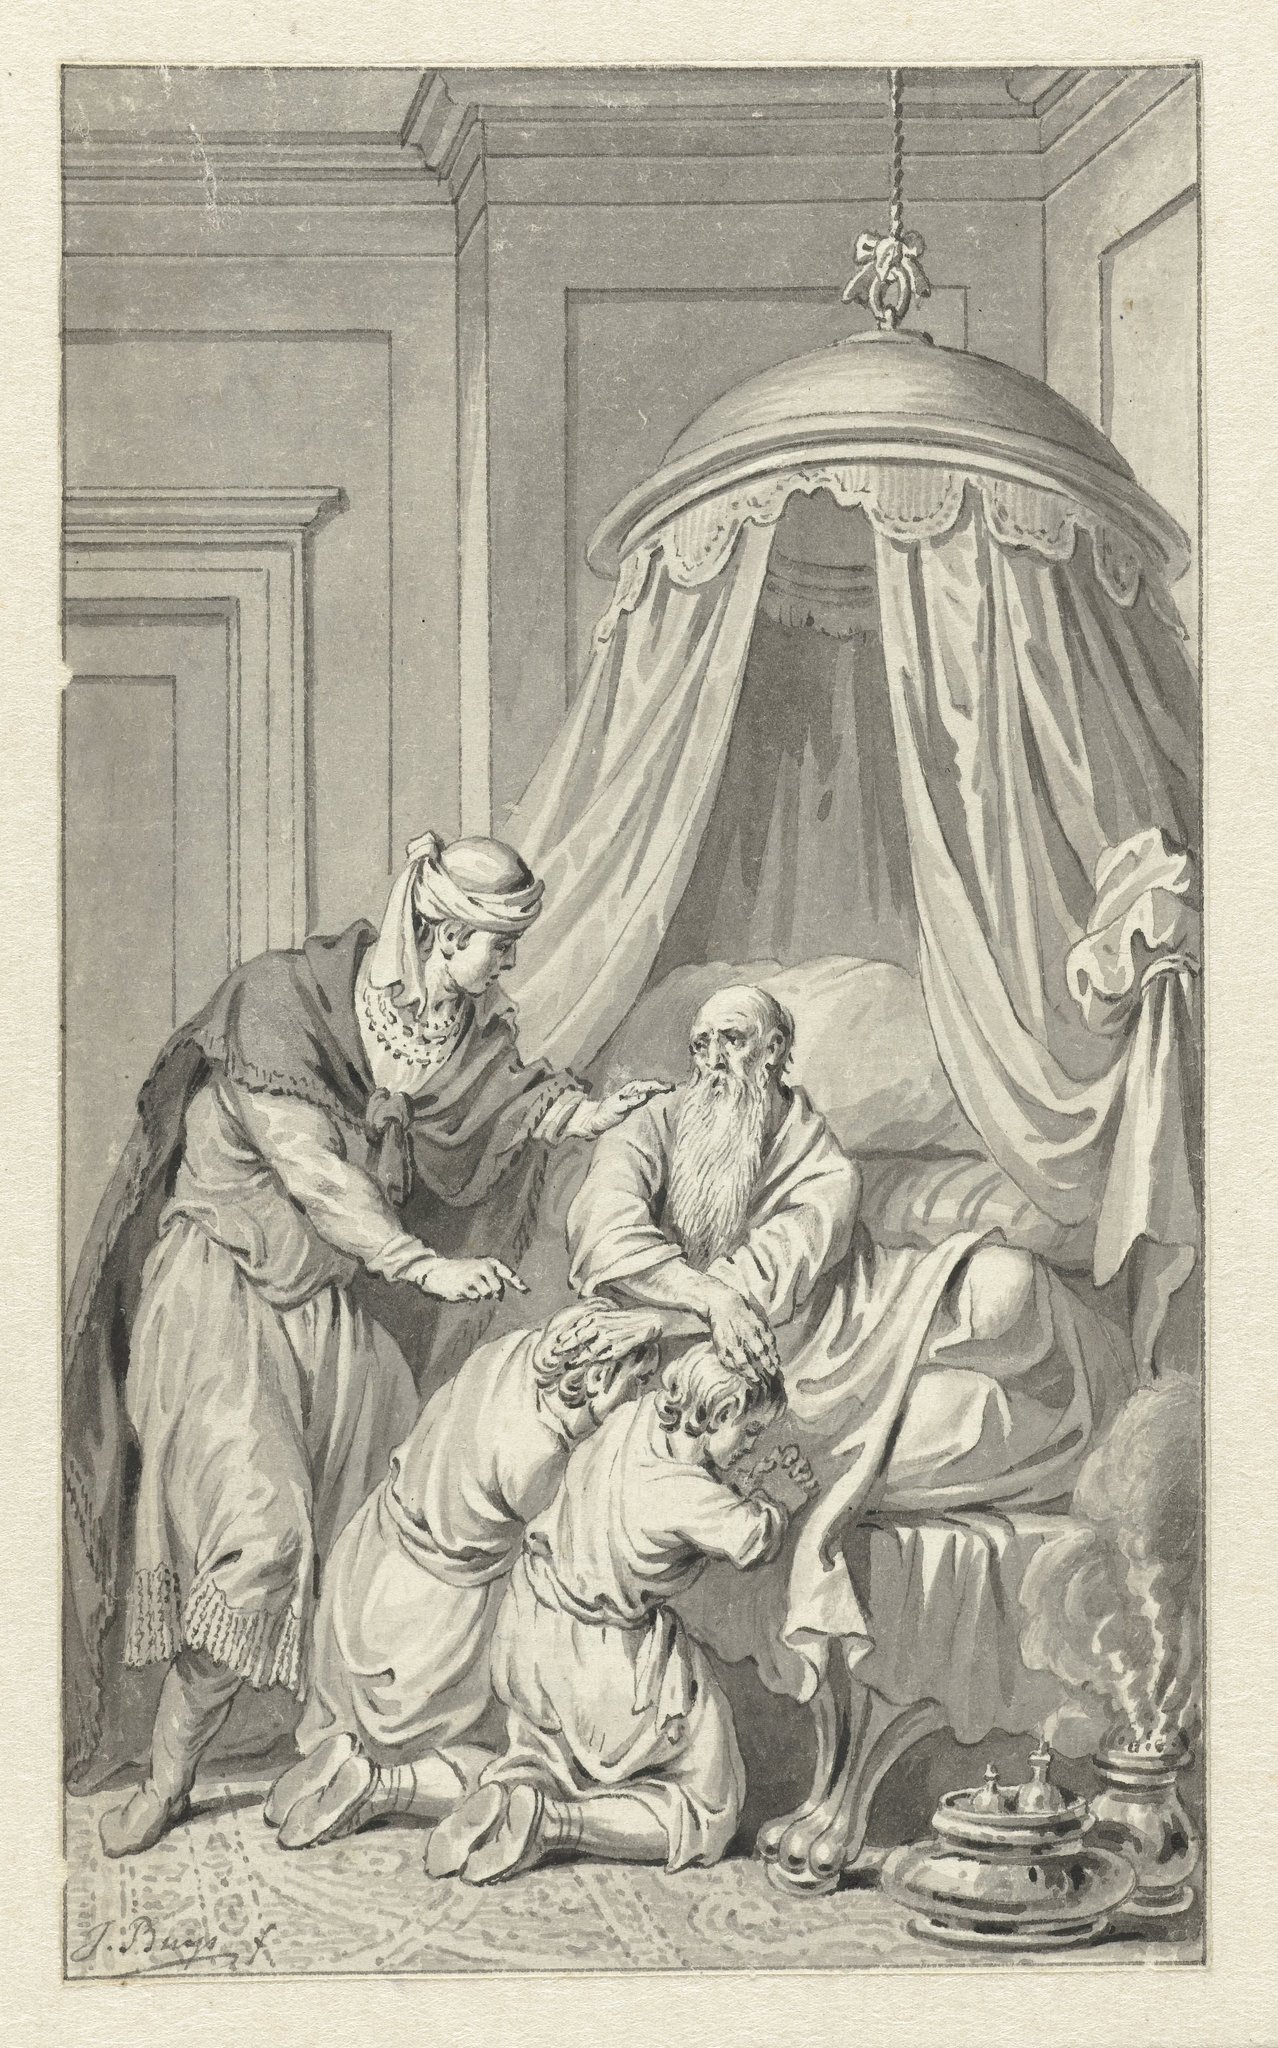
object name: design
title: Jakob zegent Manasse en Efraïm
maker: jacobus buys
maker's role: draughtsman, print maker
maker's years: 1724-1801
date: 1734-1801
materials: ink, paper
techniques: brush, pen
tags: jacob blesses manasseh and ephraim with arms crossed; joseph may be shown trying to uncross them or expressing (with asenath) his disapproval